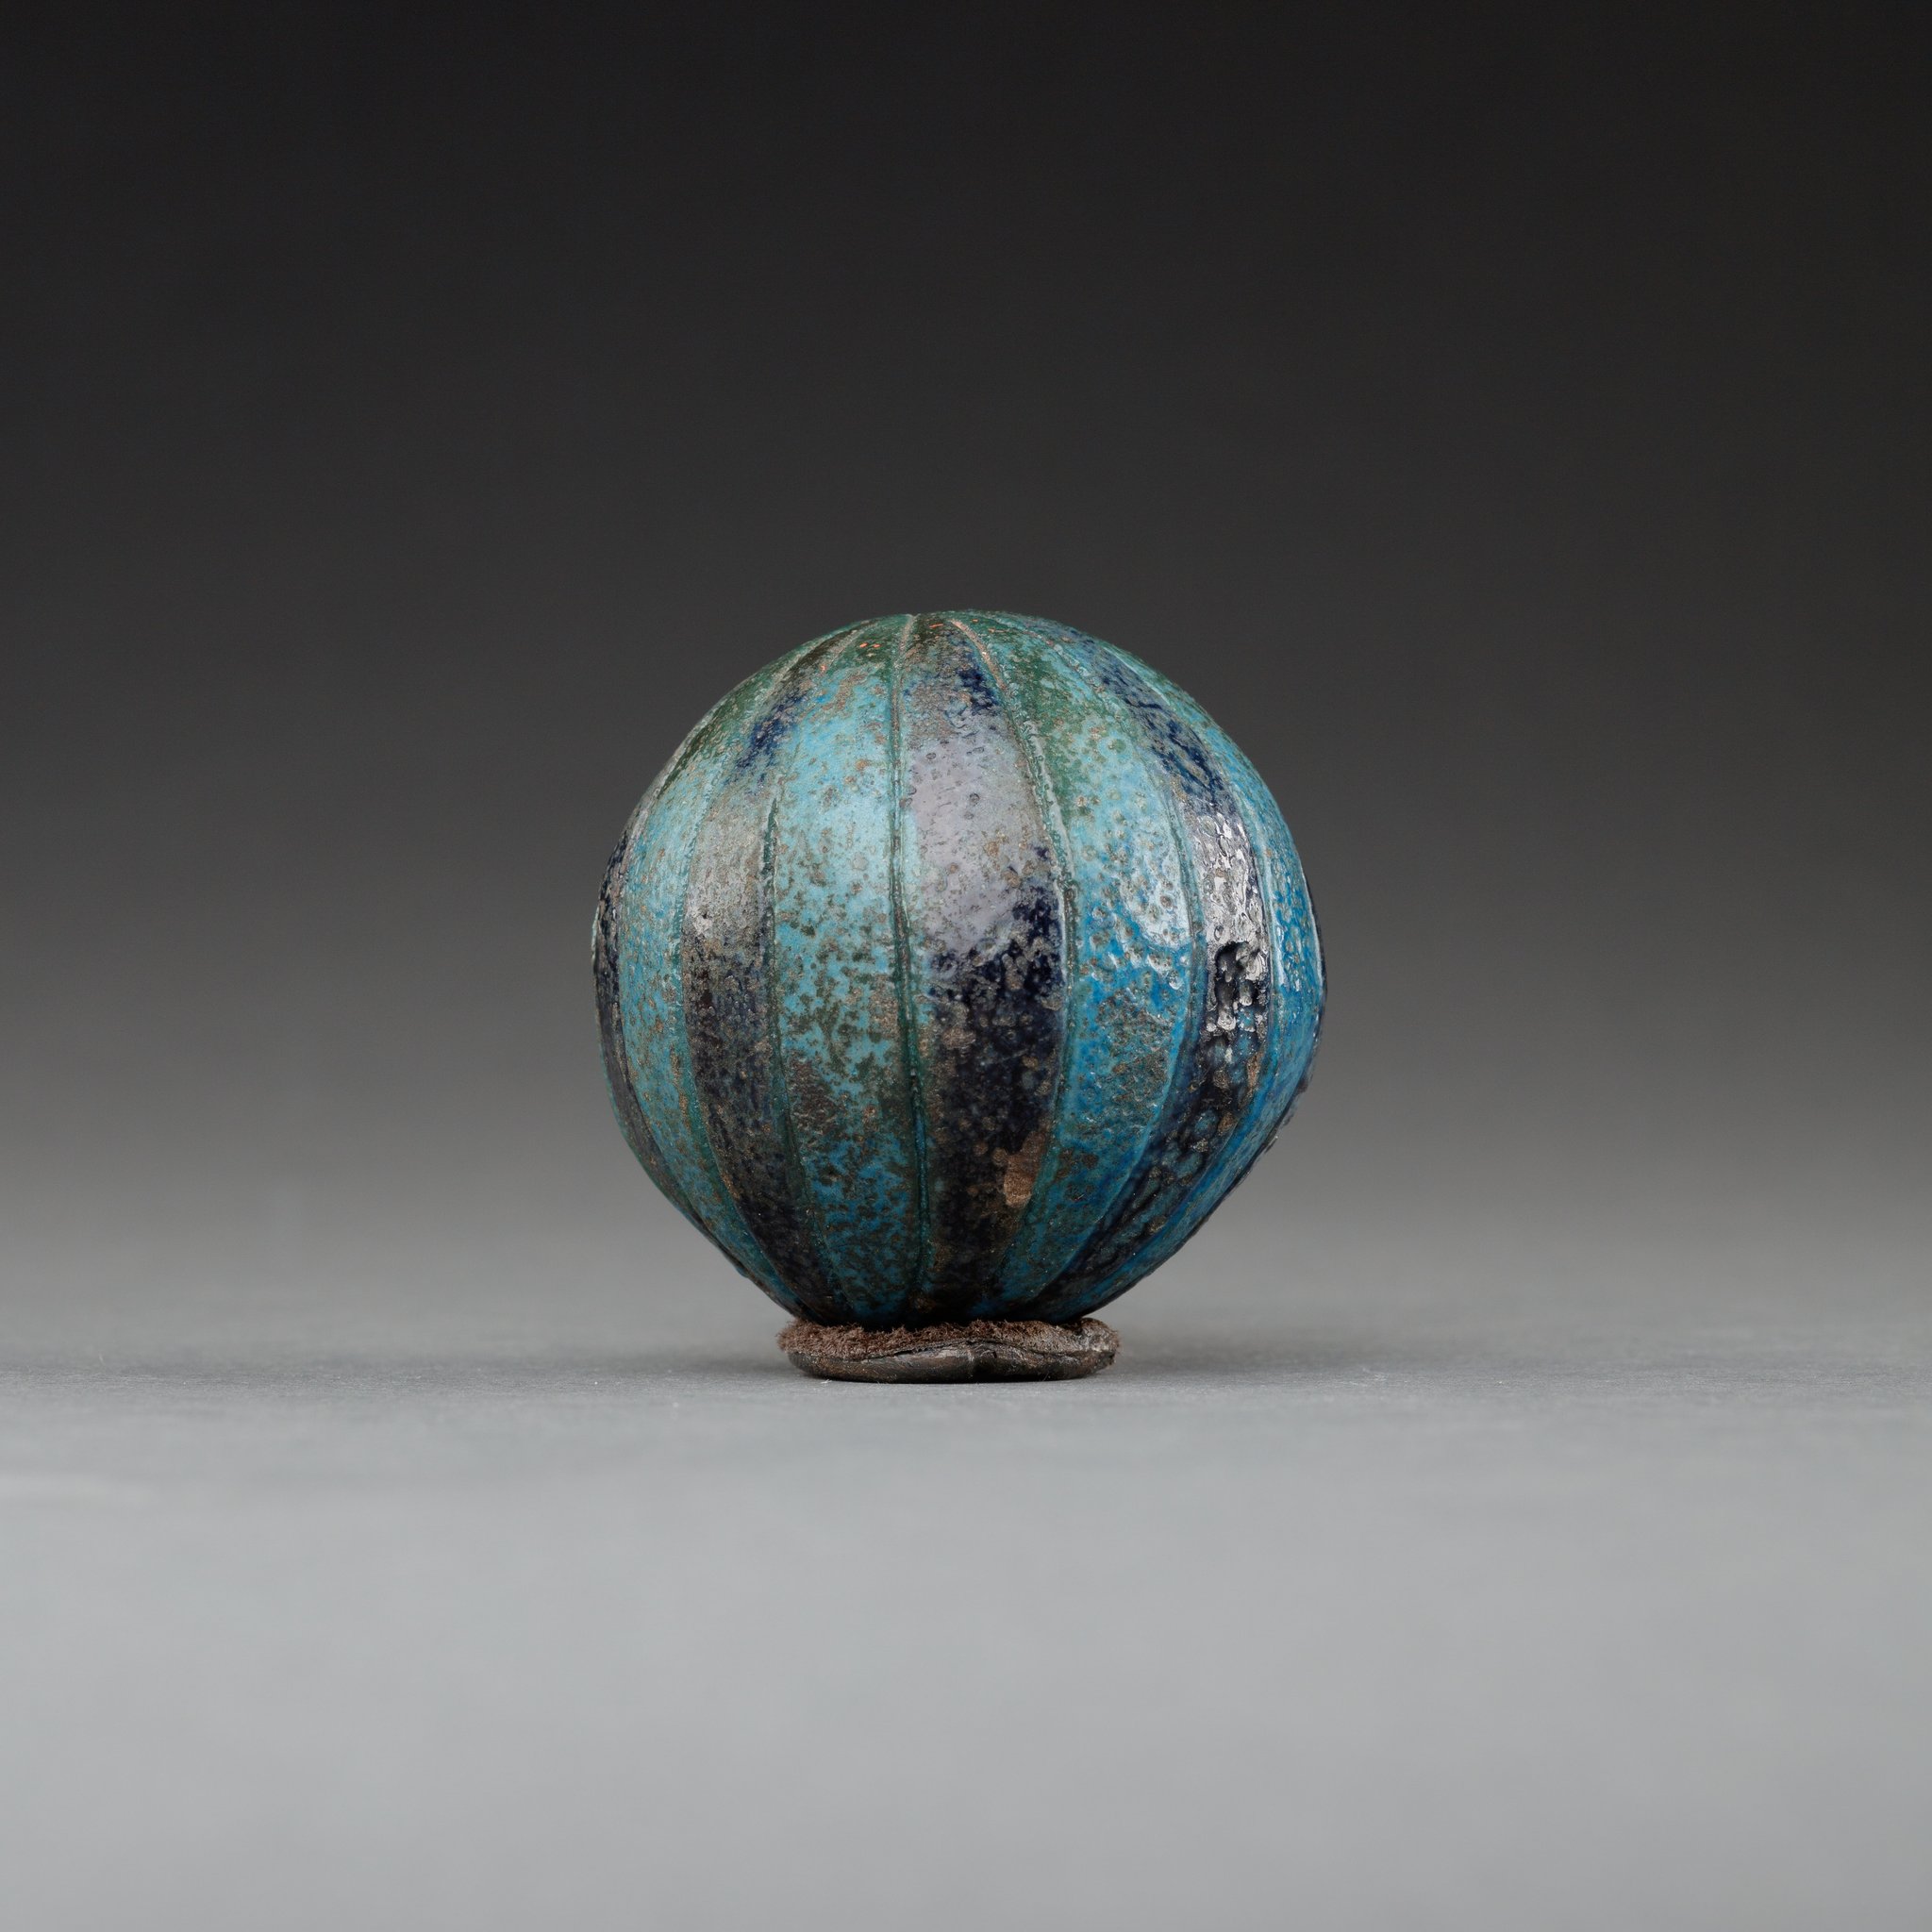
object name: segmented ball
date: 1550-1295 BCE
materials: faience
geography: egypt